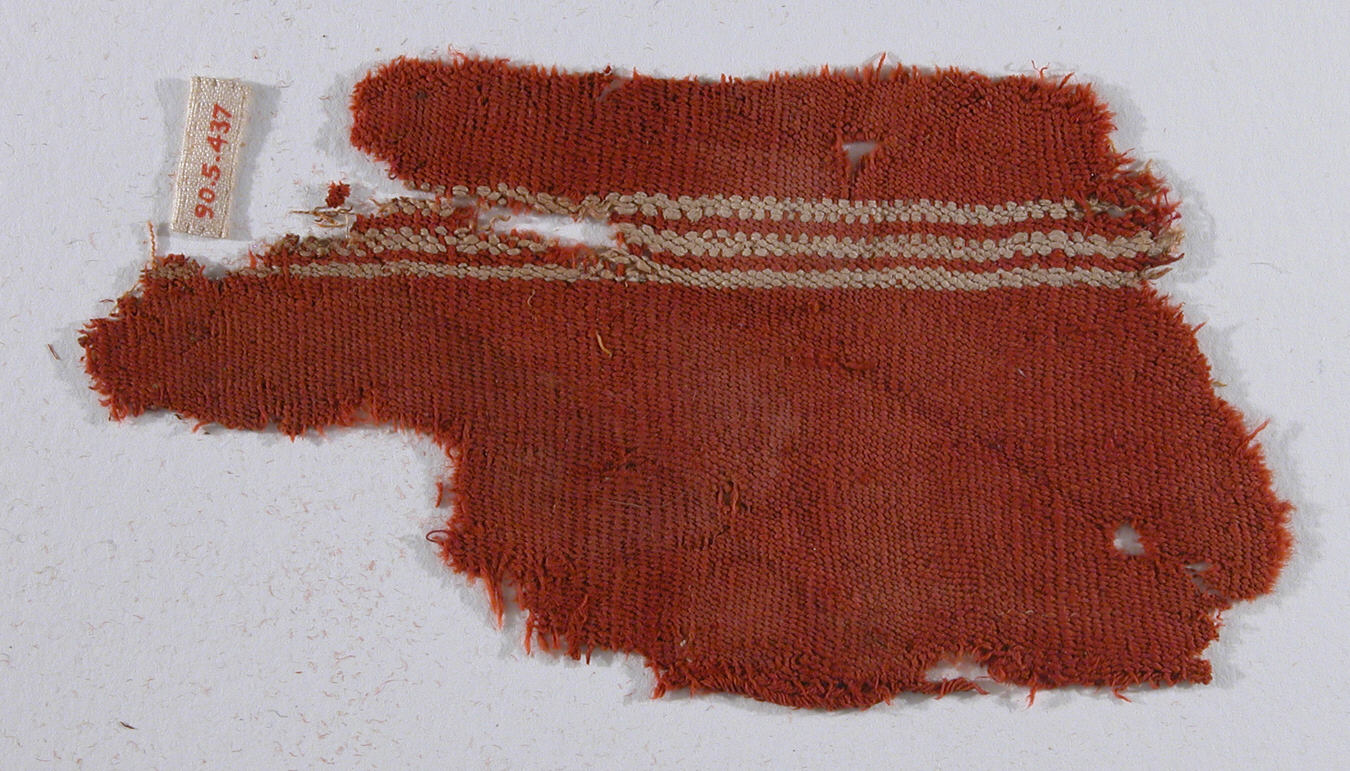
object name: textile fragment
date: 301-500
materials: linen, wool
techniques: weave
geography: egypt